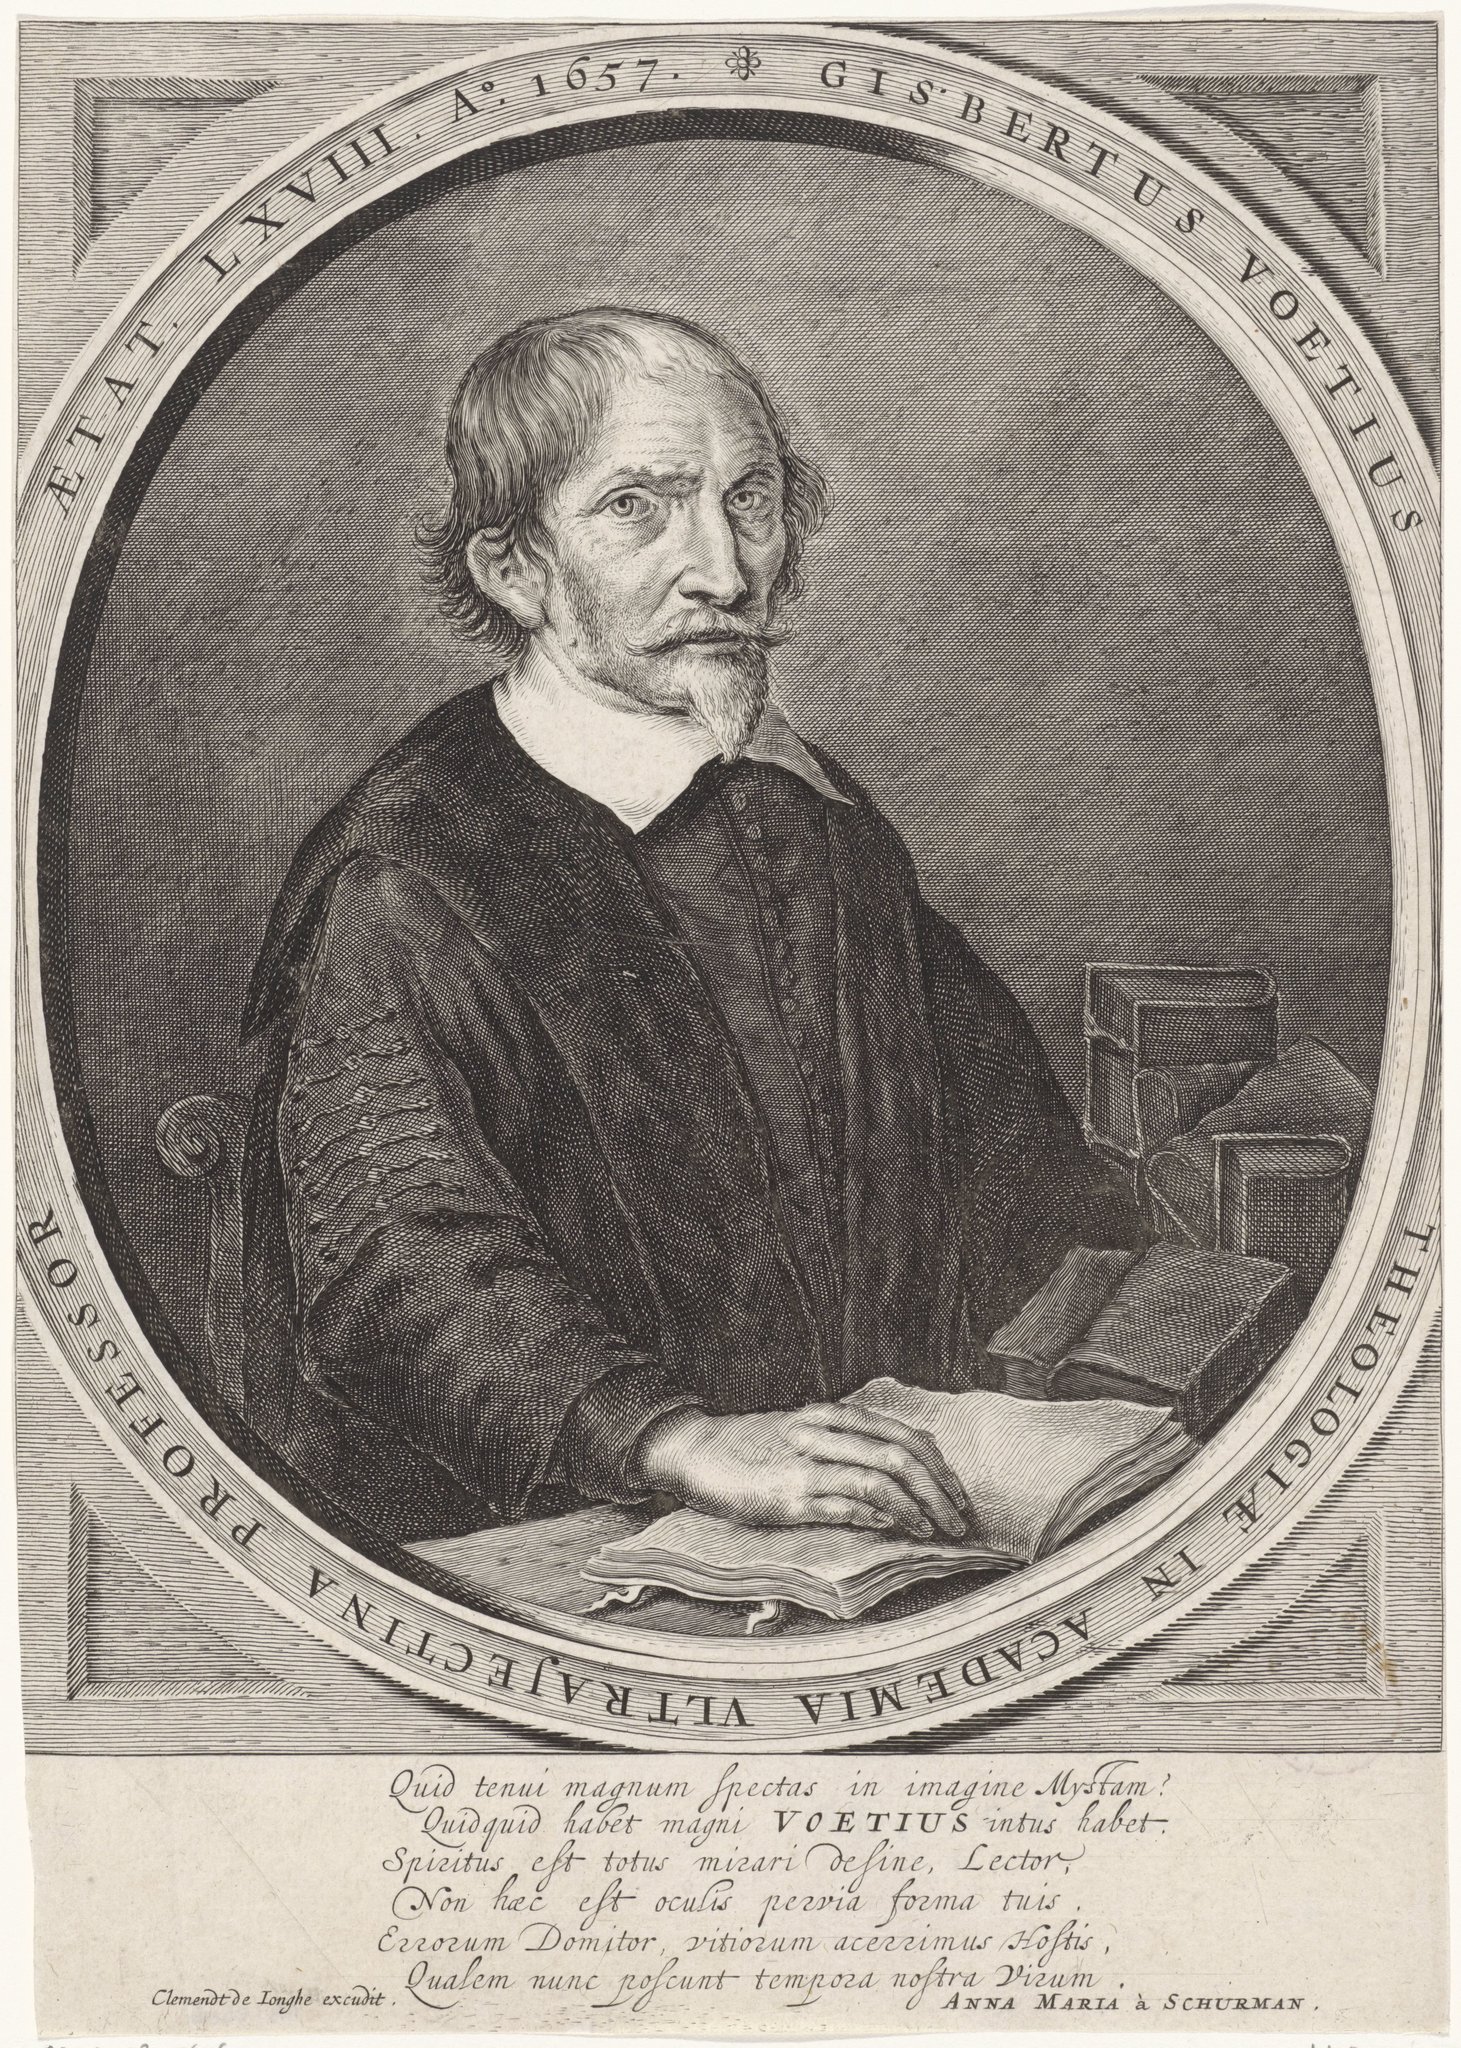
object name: print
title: Portret van Gijsbert Voet, theoloog te Utrecht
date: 1657-1670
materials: paper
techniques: engraving, etching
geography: amsterdam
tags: utrecht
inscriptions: collector's mark: Lugt 240